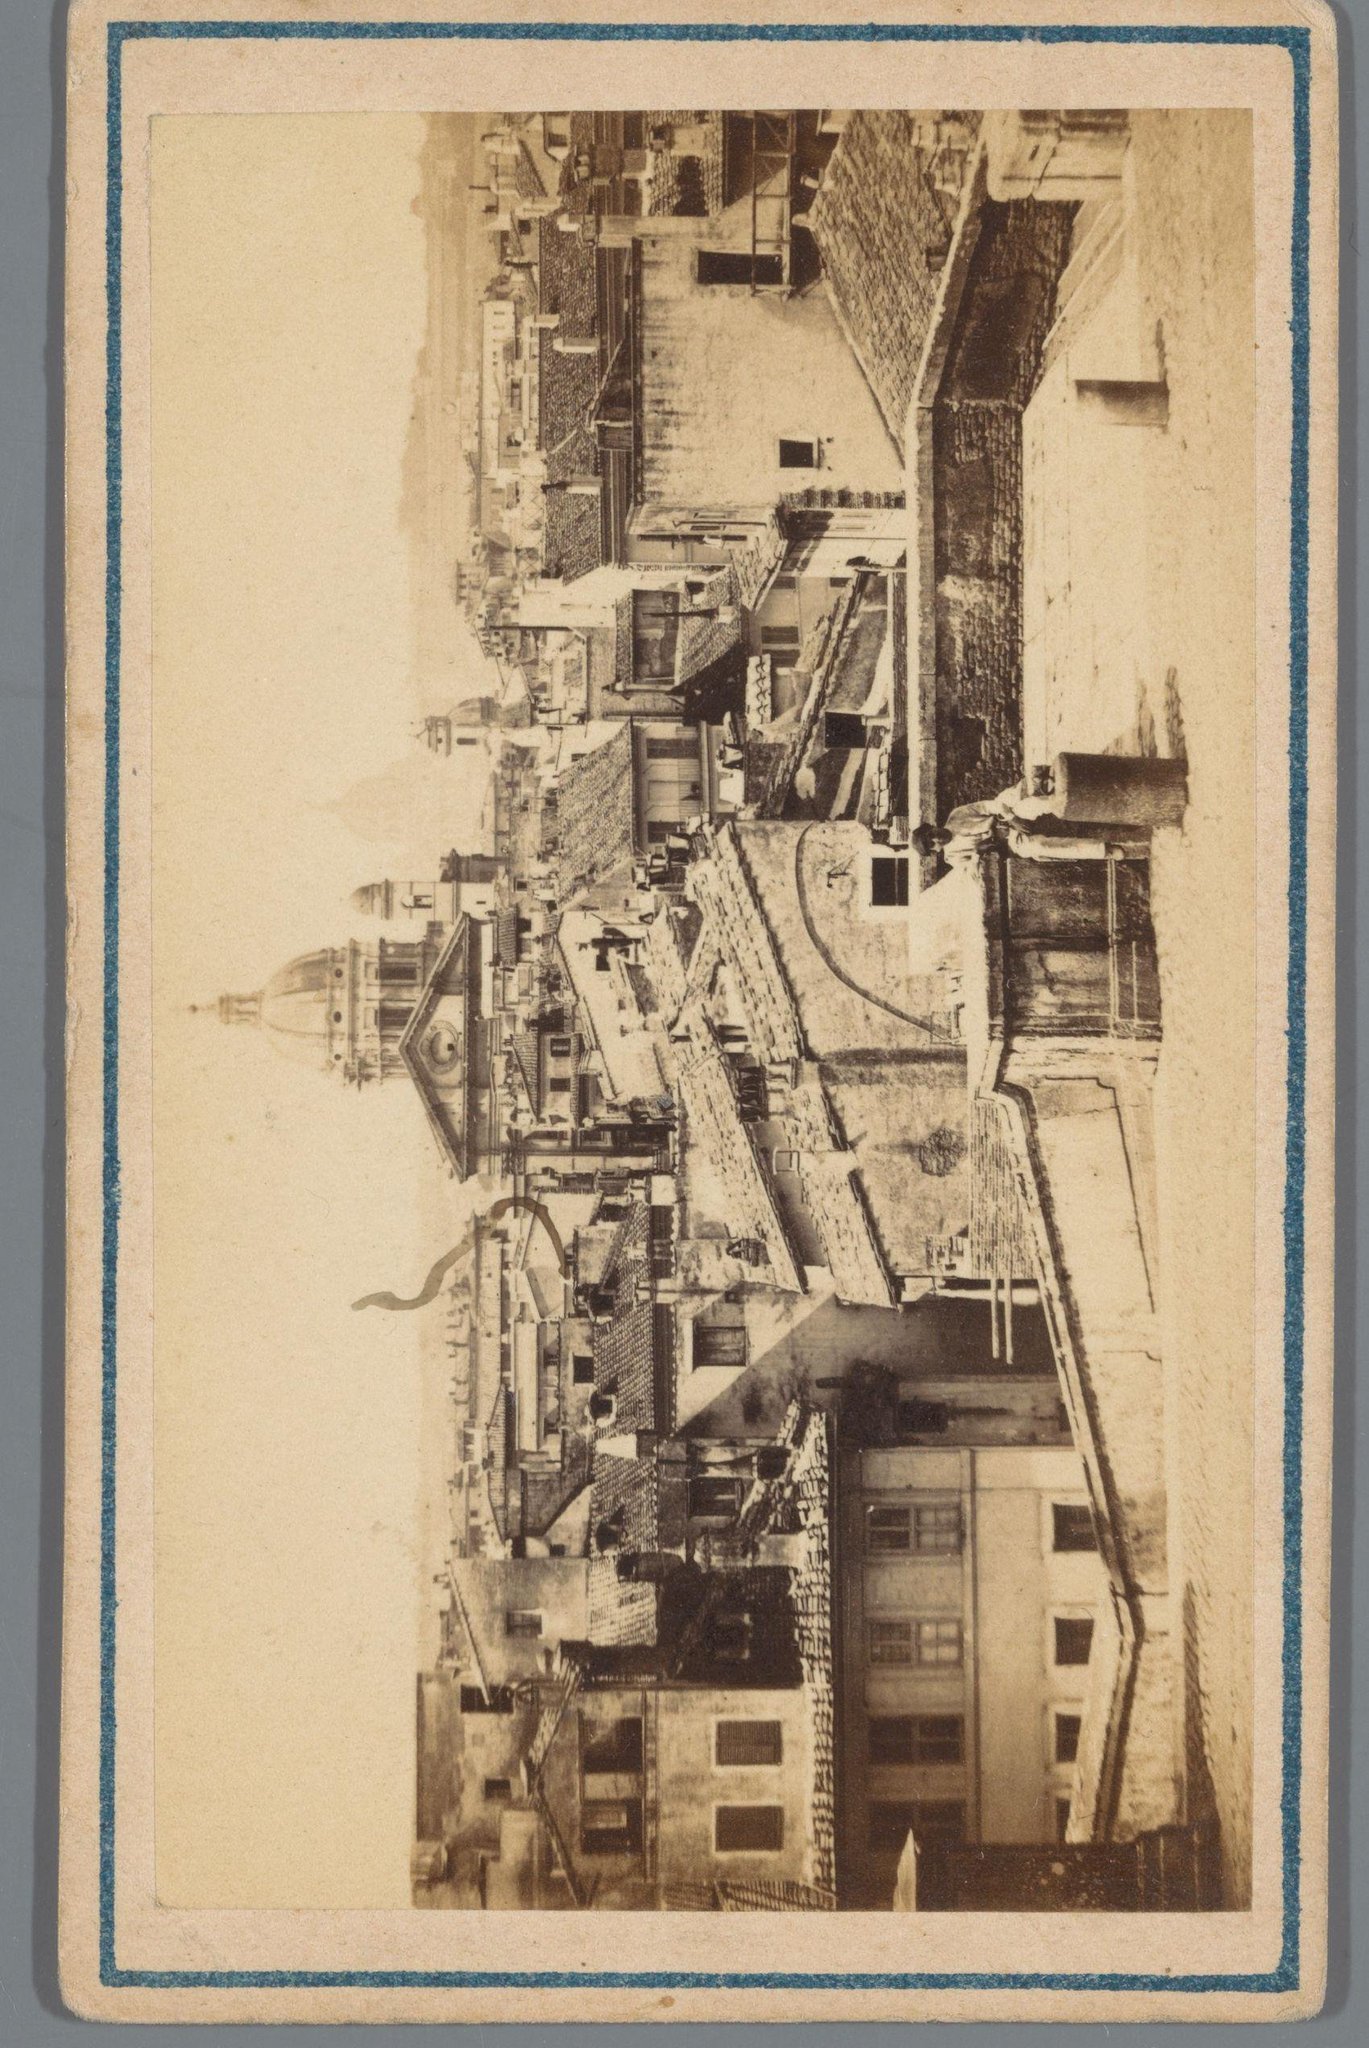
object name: carte de visite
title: Gezicht op Rome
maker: Anonymous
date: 1855-1885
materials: cardboard, paper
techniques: albumen print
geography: rome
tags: city-view in general; 'veduta', rome